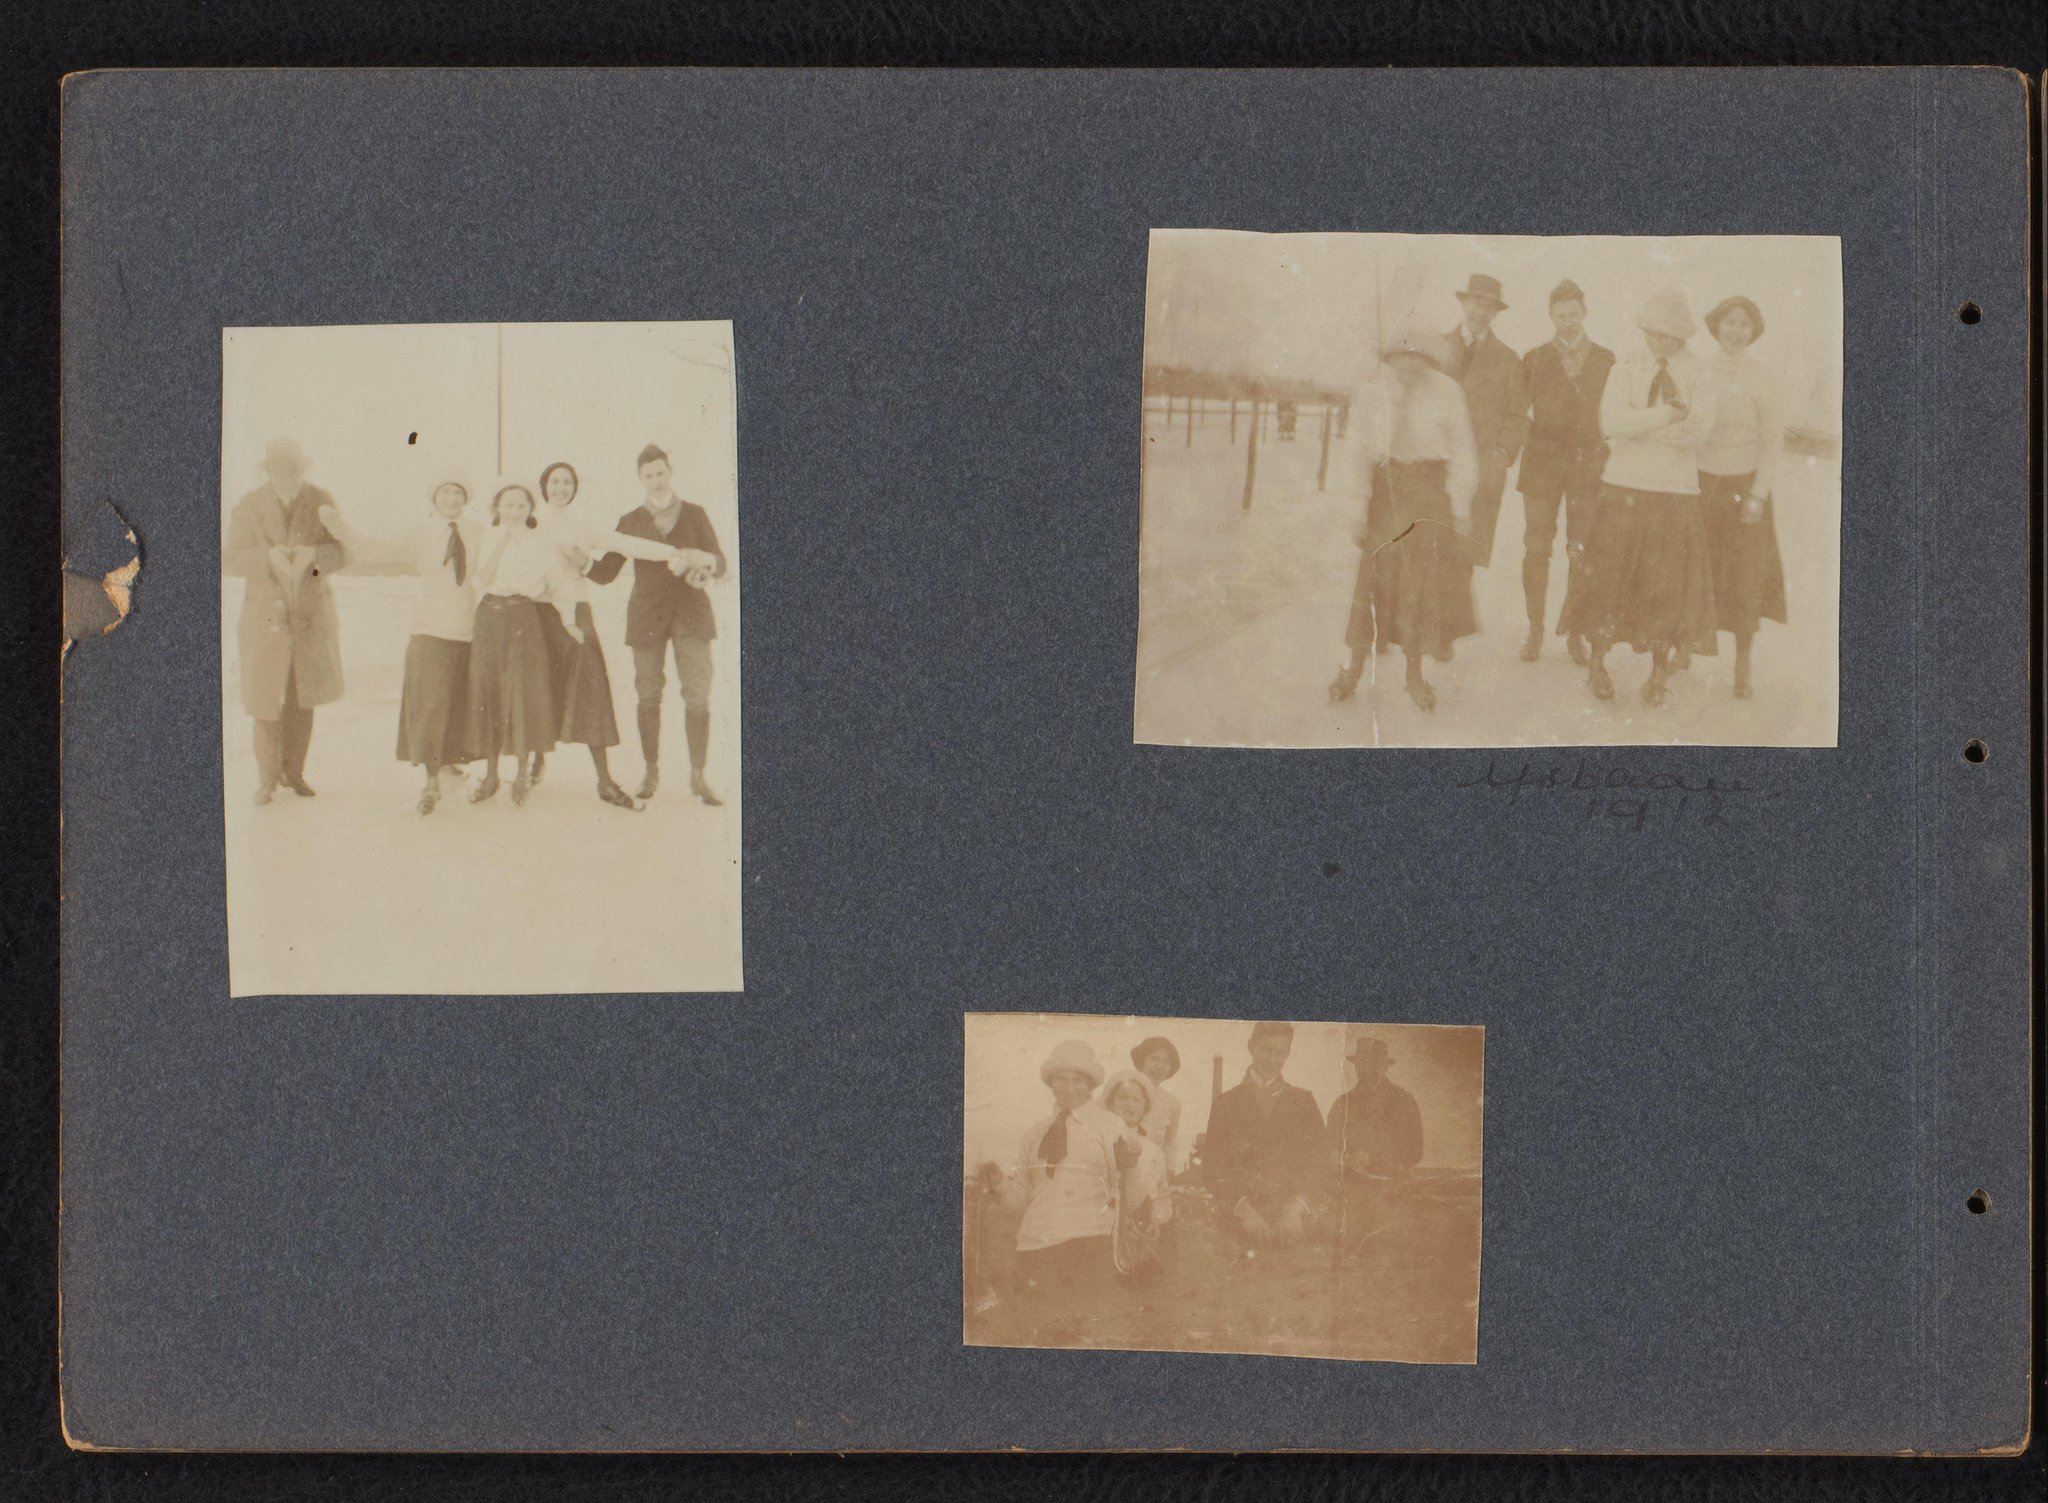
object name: album leaf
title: Gezin Onnen op een ijsbaan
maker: carolina frederika onnen (lien/loen)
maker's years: 1896-1983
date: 1912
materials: paper, cardboard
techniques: collodion silver print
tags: skates (winter sports)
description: Deze foto's zijn onderdeel van een album.